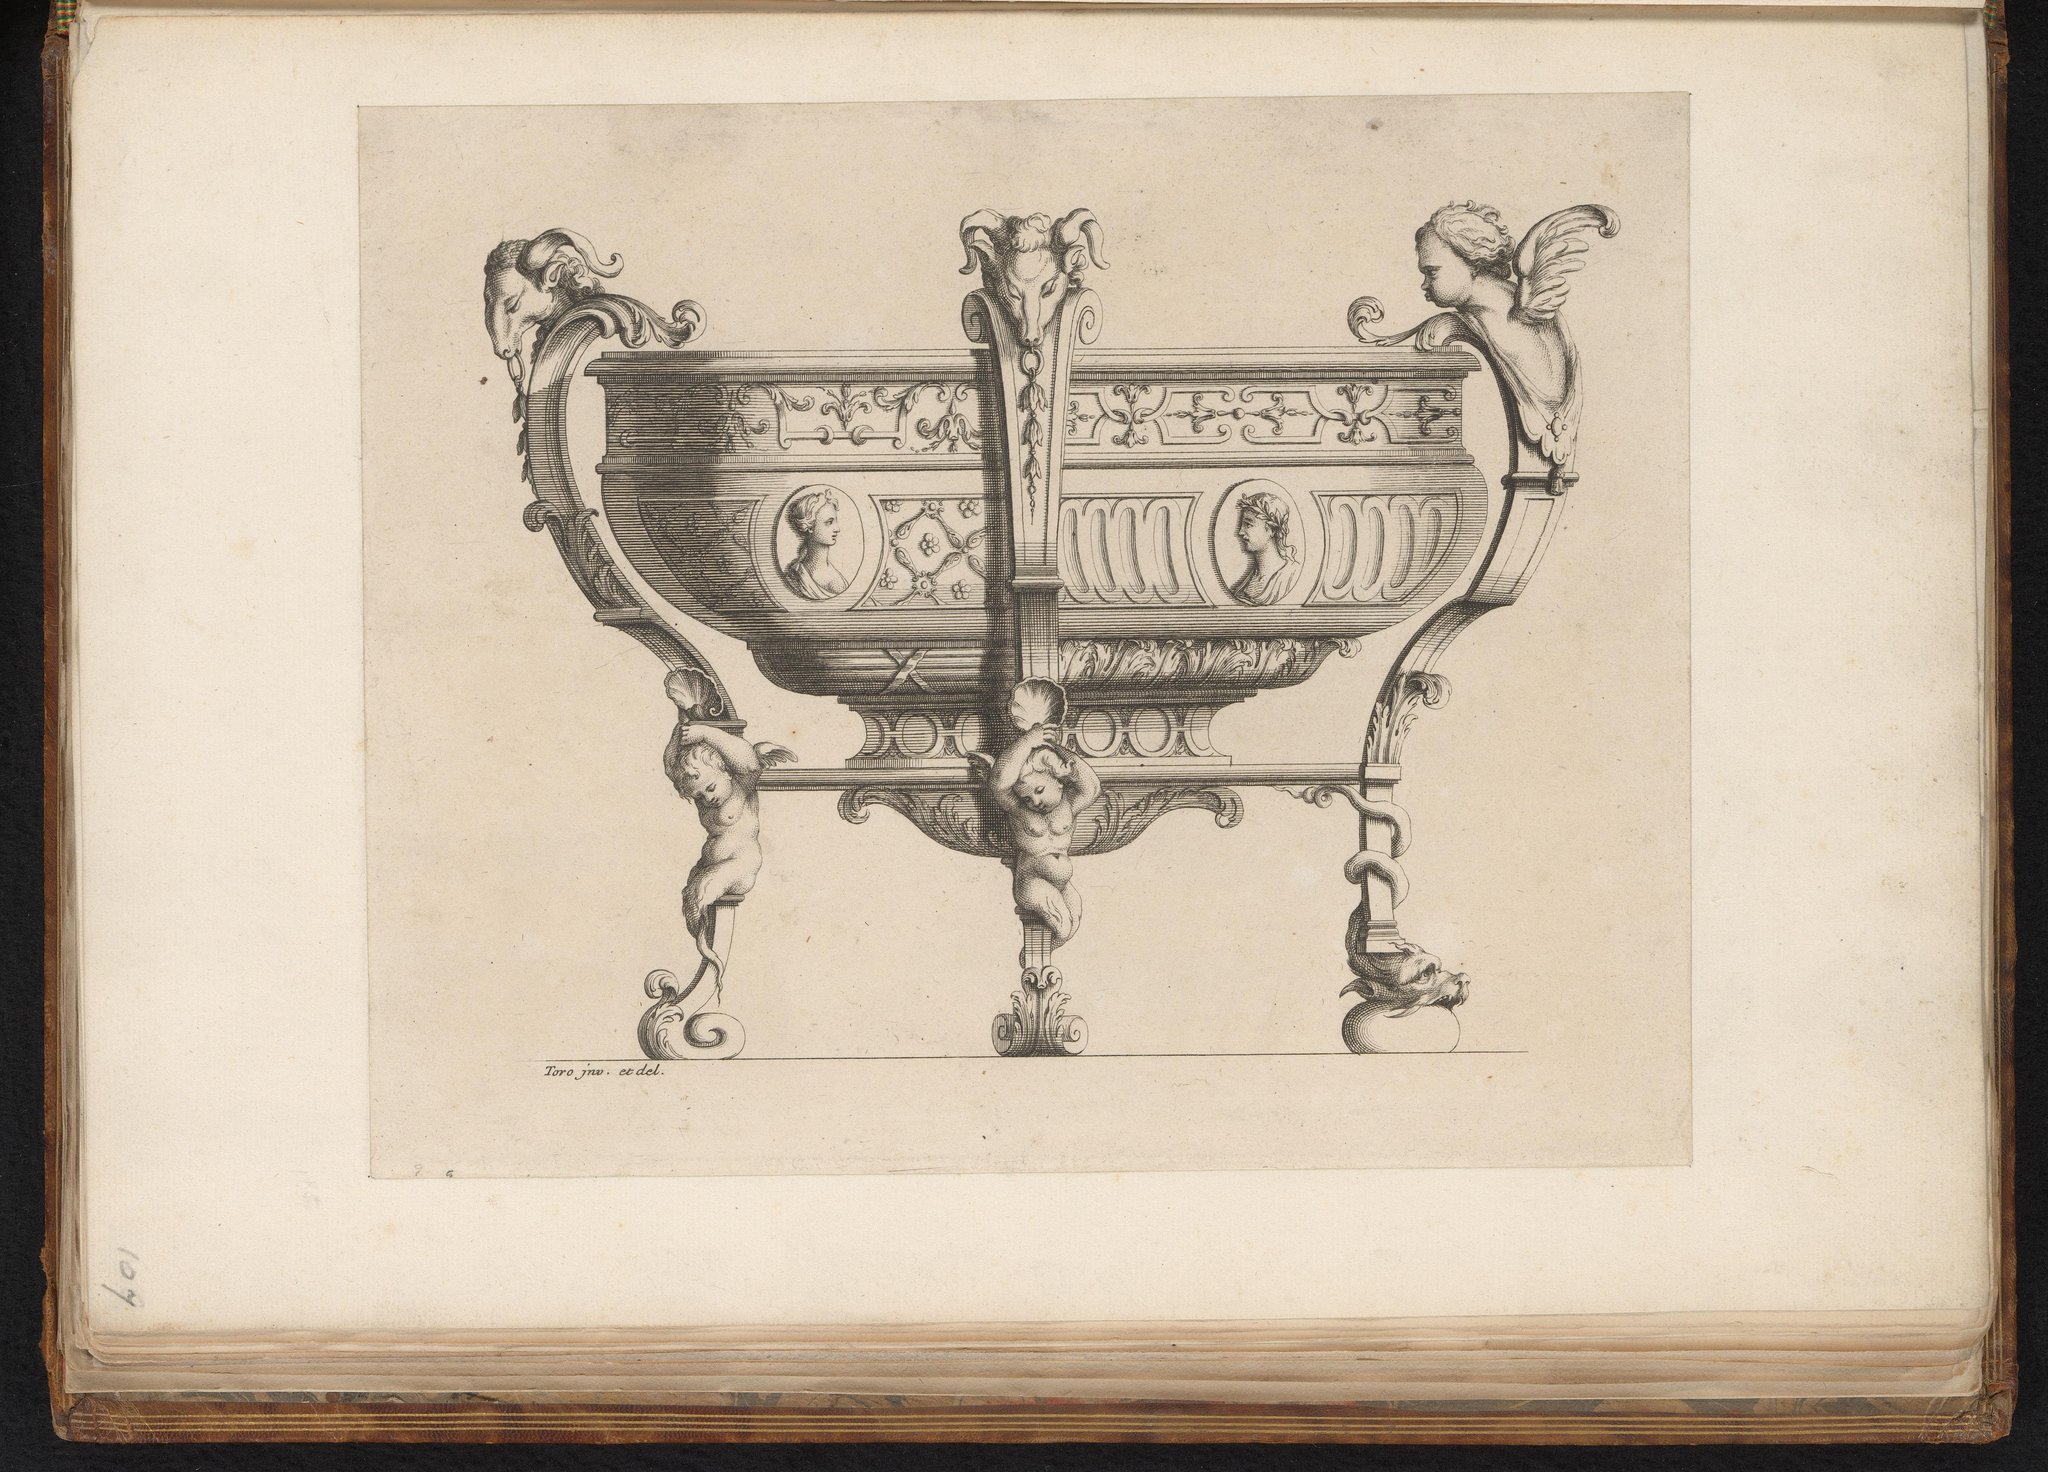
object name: album leaf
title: Schaal op standaard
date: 1682-1731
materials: paper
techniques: etching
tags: ram's head ~ ornament, dish, plate, saucer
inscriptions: collector's mark: Lugt 2760, collector's mark: Lugt 2228